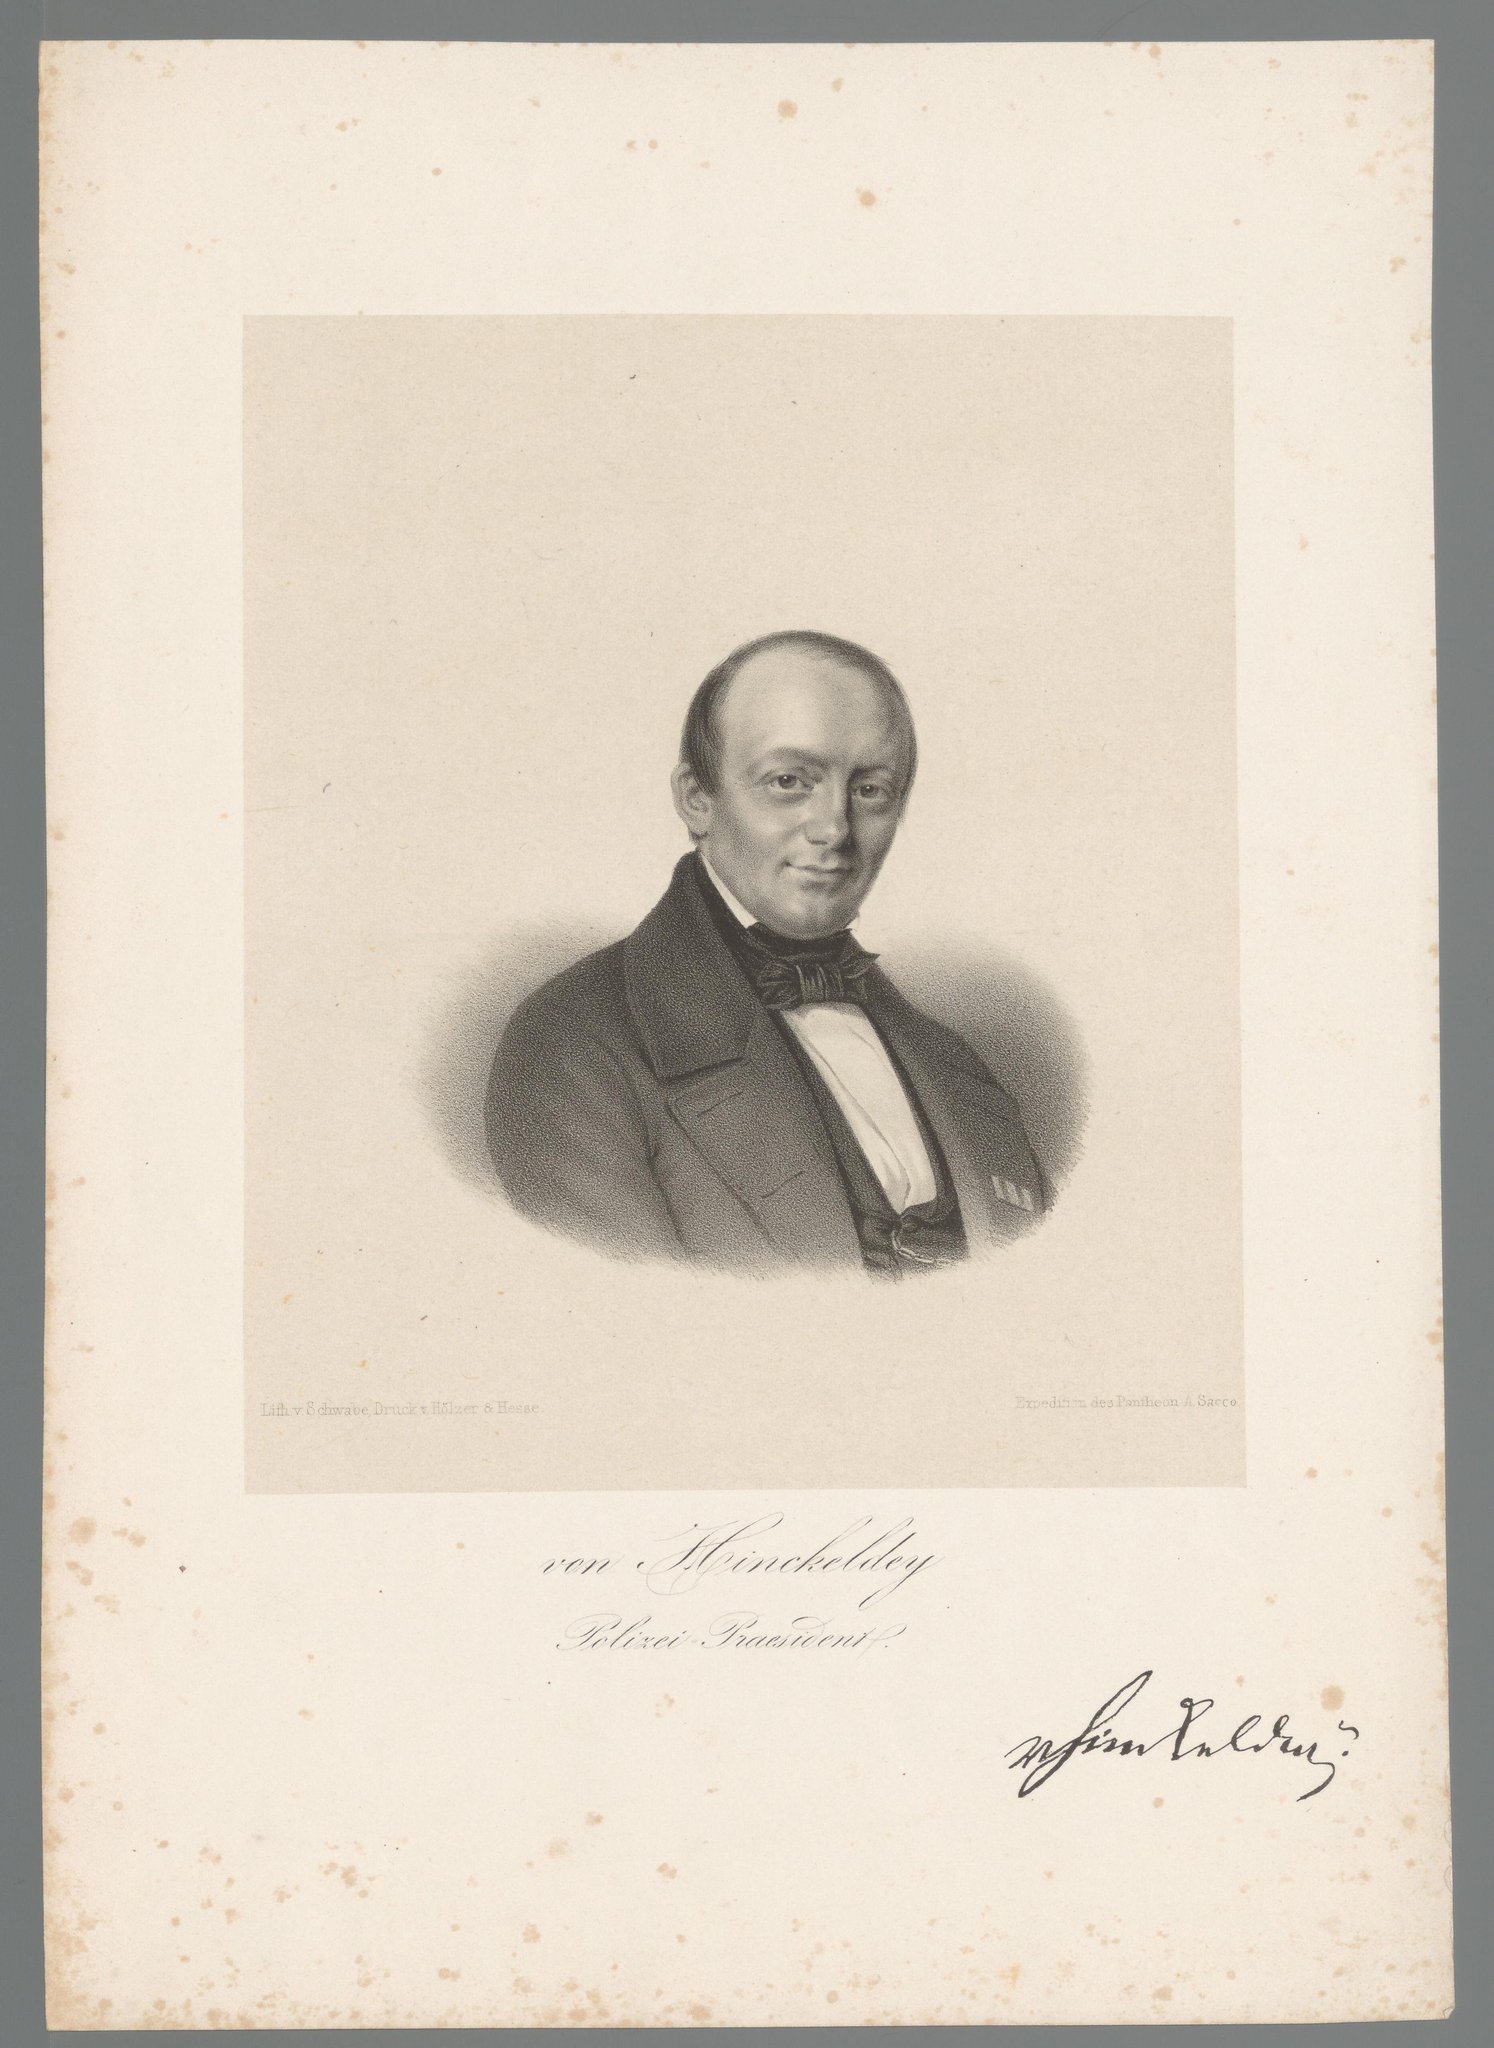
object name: print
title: Pantheon-expeditie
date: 1830-1860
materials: paper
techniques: lithograph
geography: berlin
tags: adult man, historical persons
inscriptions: collector's mark: Lugt 2228